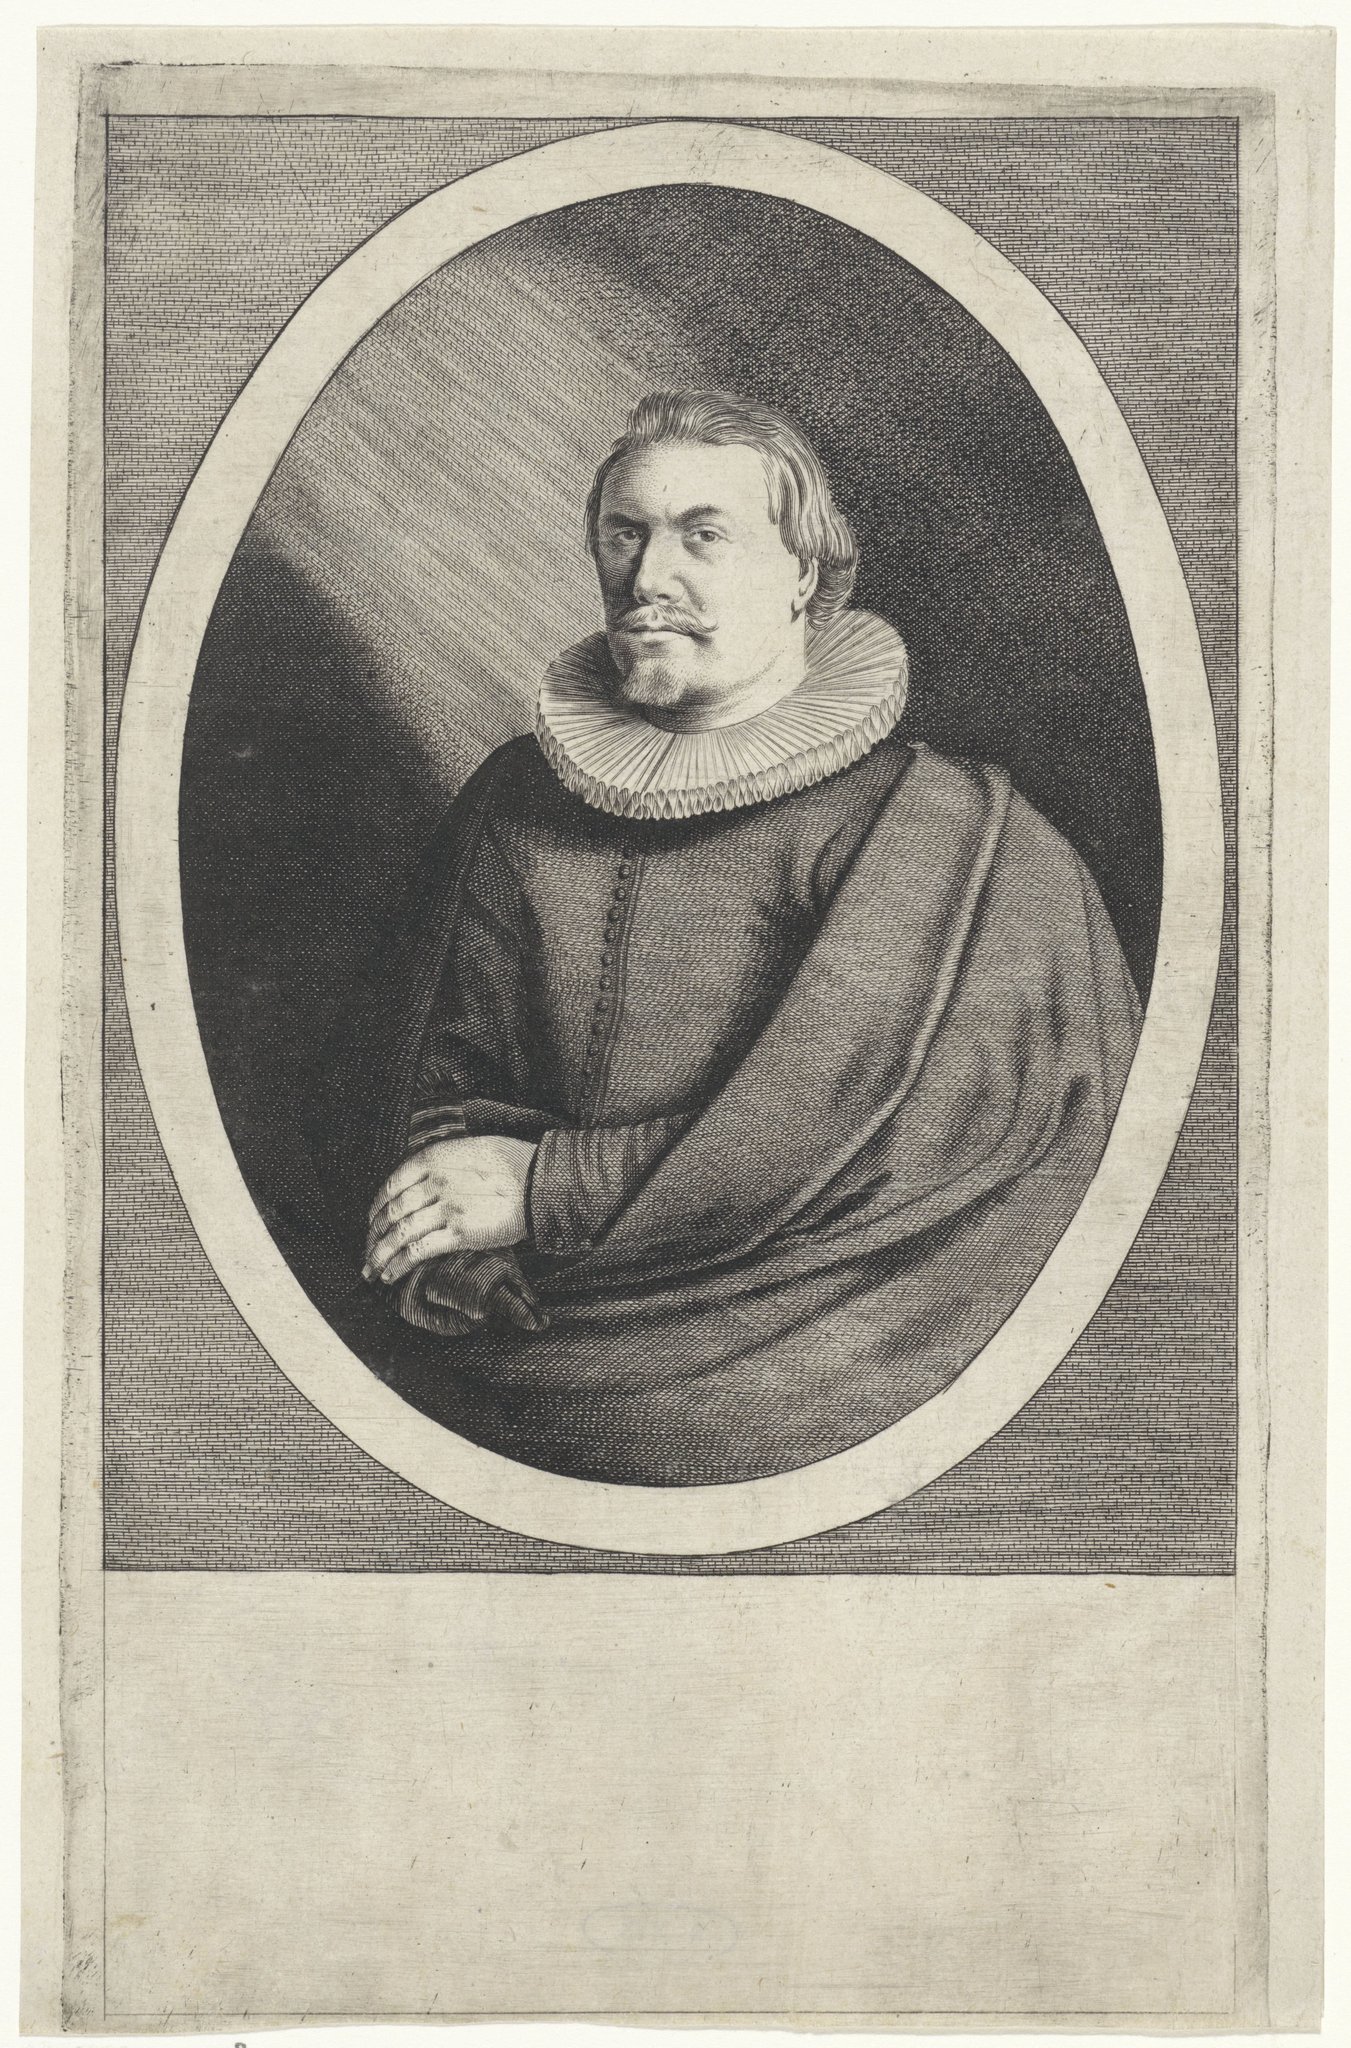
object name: print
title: Portret van Albert Harmensz Dingsteden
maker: jan van de velde (ii)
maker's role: draughtsman, painter, print maker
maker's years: 1593-1641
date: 1636-1641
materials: paper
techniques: engraving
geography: northern netherlands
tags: albert harmensz dingsteden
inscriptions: collector's mark: Lugt 2228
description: De Amsterdamse burger Albert Harmensz Dingsteden op 25-jarige leeftijd. Dingstede werd in 1629 verbannen wegens Remonstrantse sympathieën.